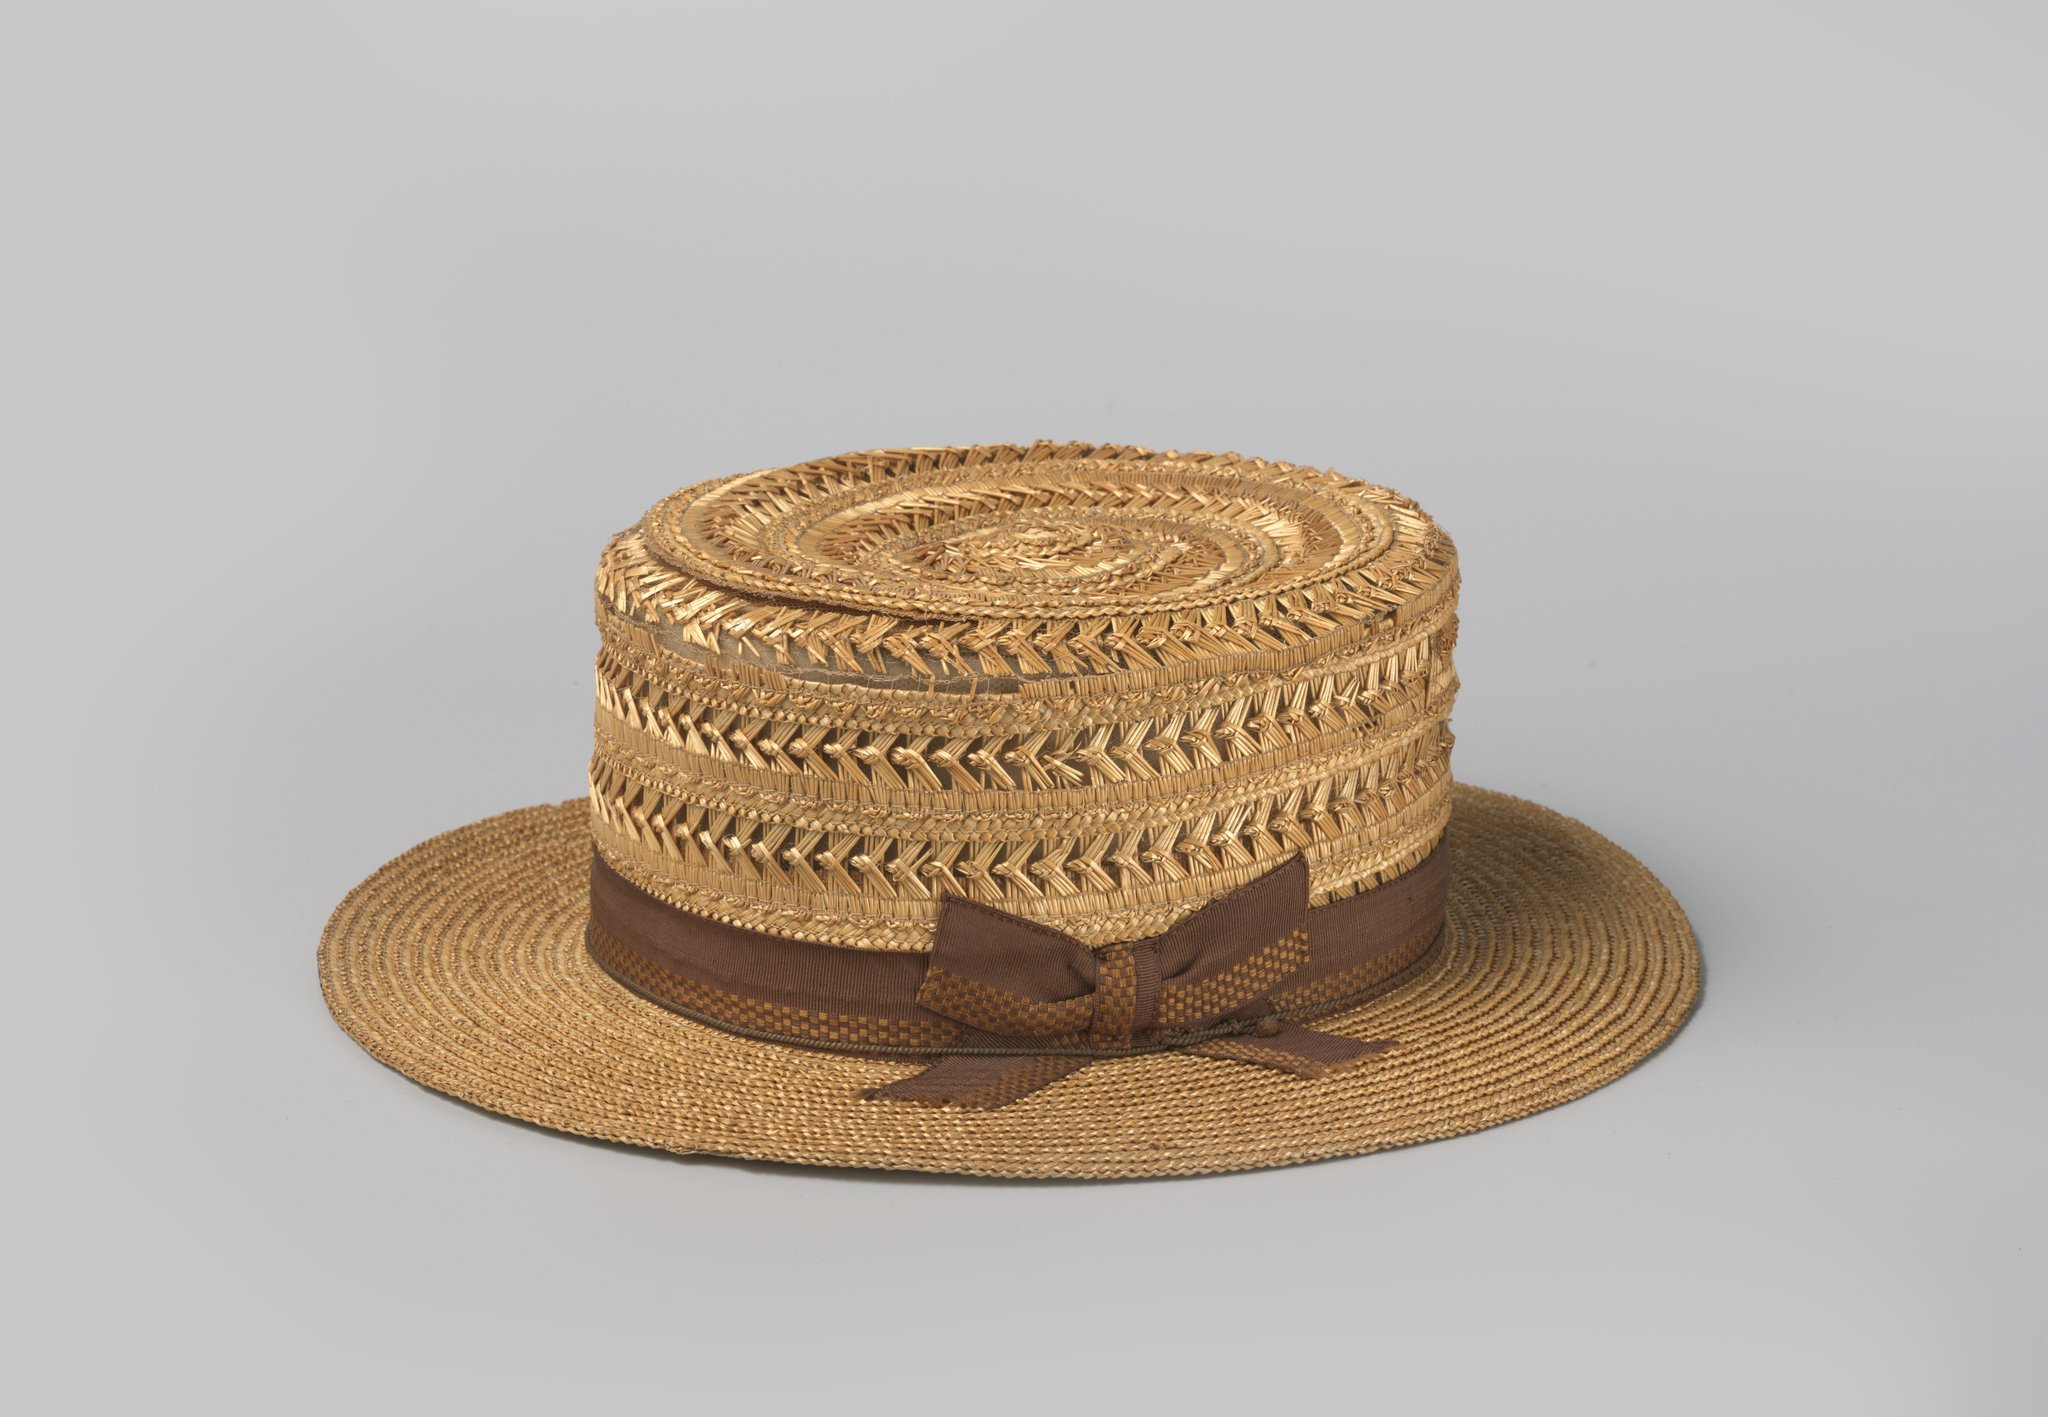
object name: straw hat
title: Hoed van naturel kleurig stro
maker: Anonymous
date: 1900-1930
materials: leather, textile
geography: western europe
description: Hoed van naturel kleurig stro, van genaaide open en dichte stroband, met bruin lint met half ruitpatroon half effen patroon. Model: Hoog, ovaal, plat. Donkerbruin leren hoofdband. Beige satinet capeline met gazen opstand.